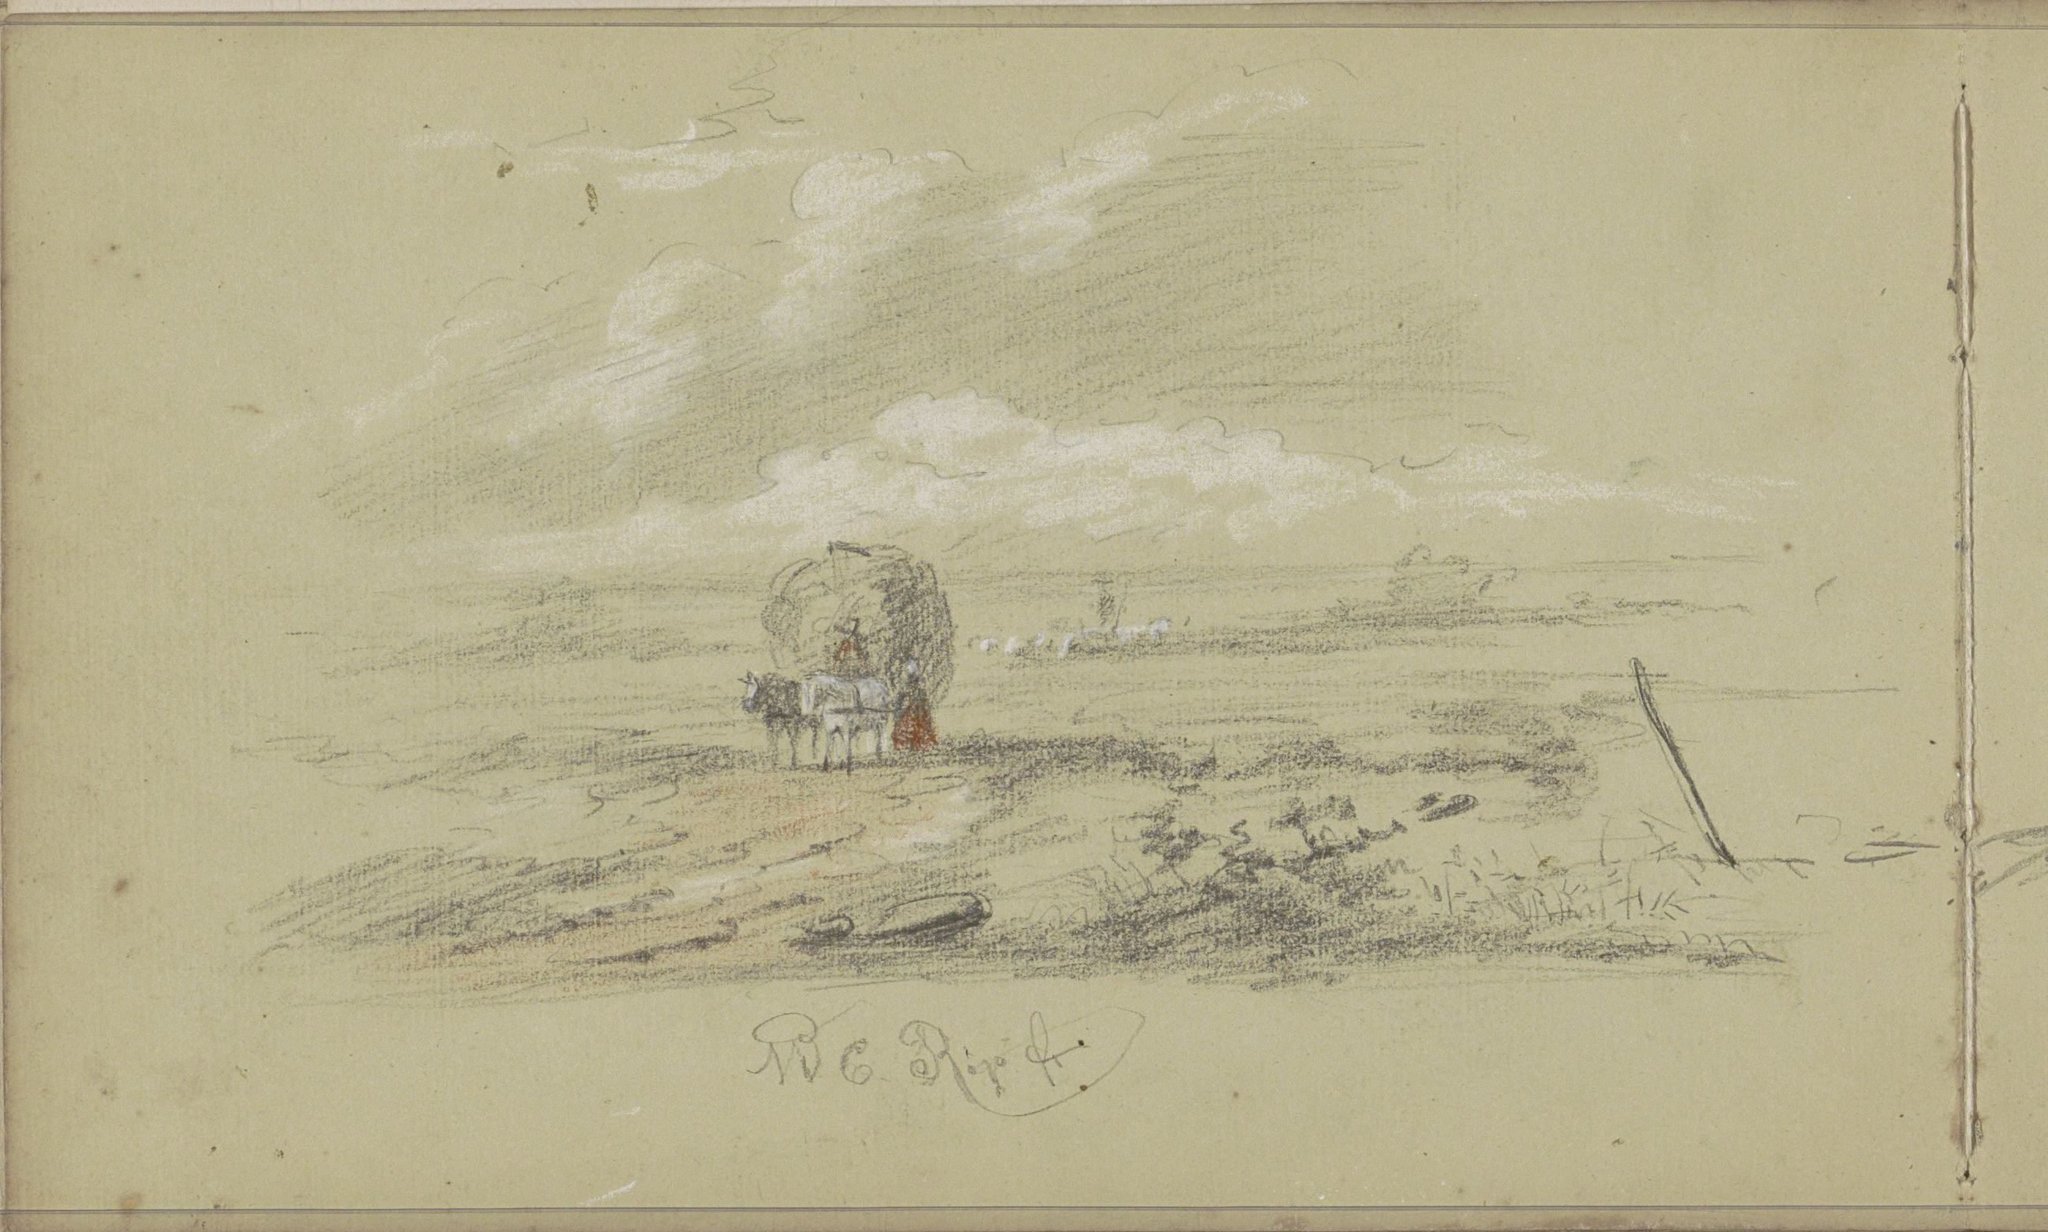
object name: sketchbook leaf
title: Landschap met een hooiwagen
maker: willem cornelis rip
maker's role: draughtsman, painter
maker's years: 1856-1922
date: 1874-1875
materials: chalk, paper, pencil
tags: landscapes (+ landscape with figures, staffage), hay-wagon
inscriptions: signature: ‘WC Rip f.’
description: Blad 42 verso uit een schetsboek met 46 bladen.